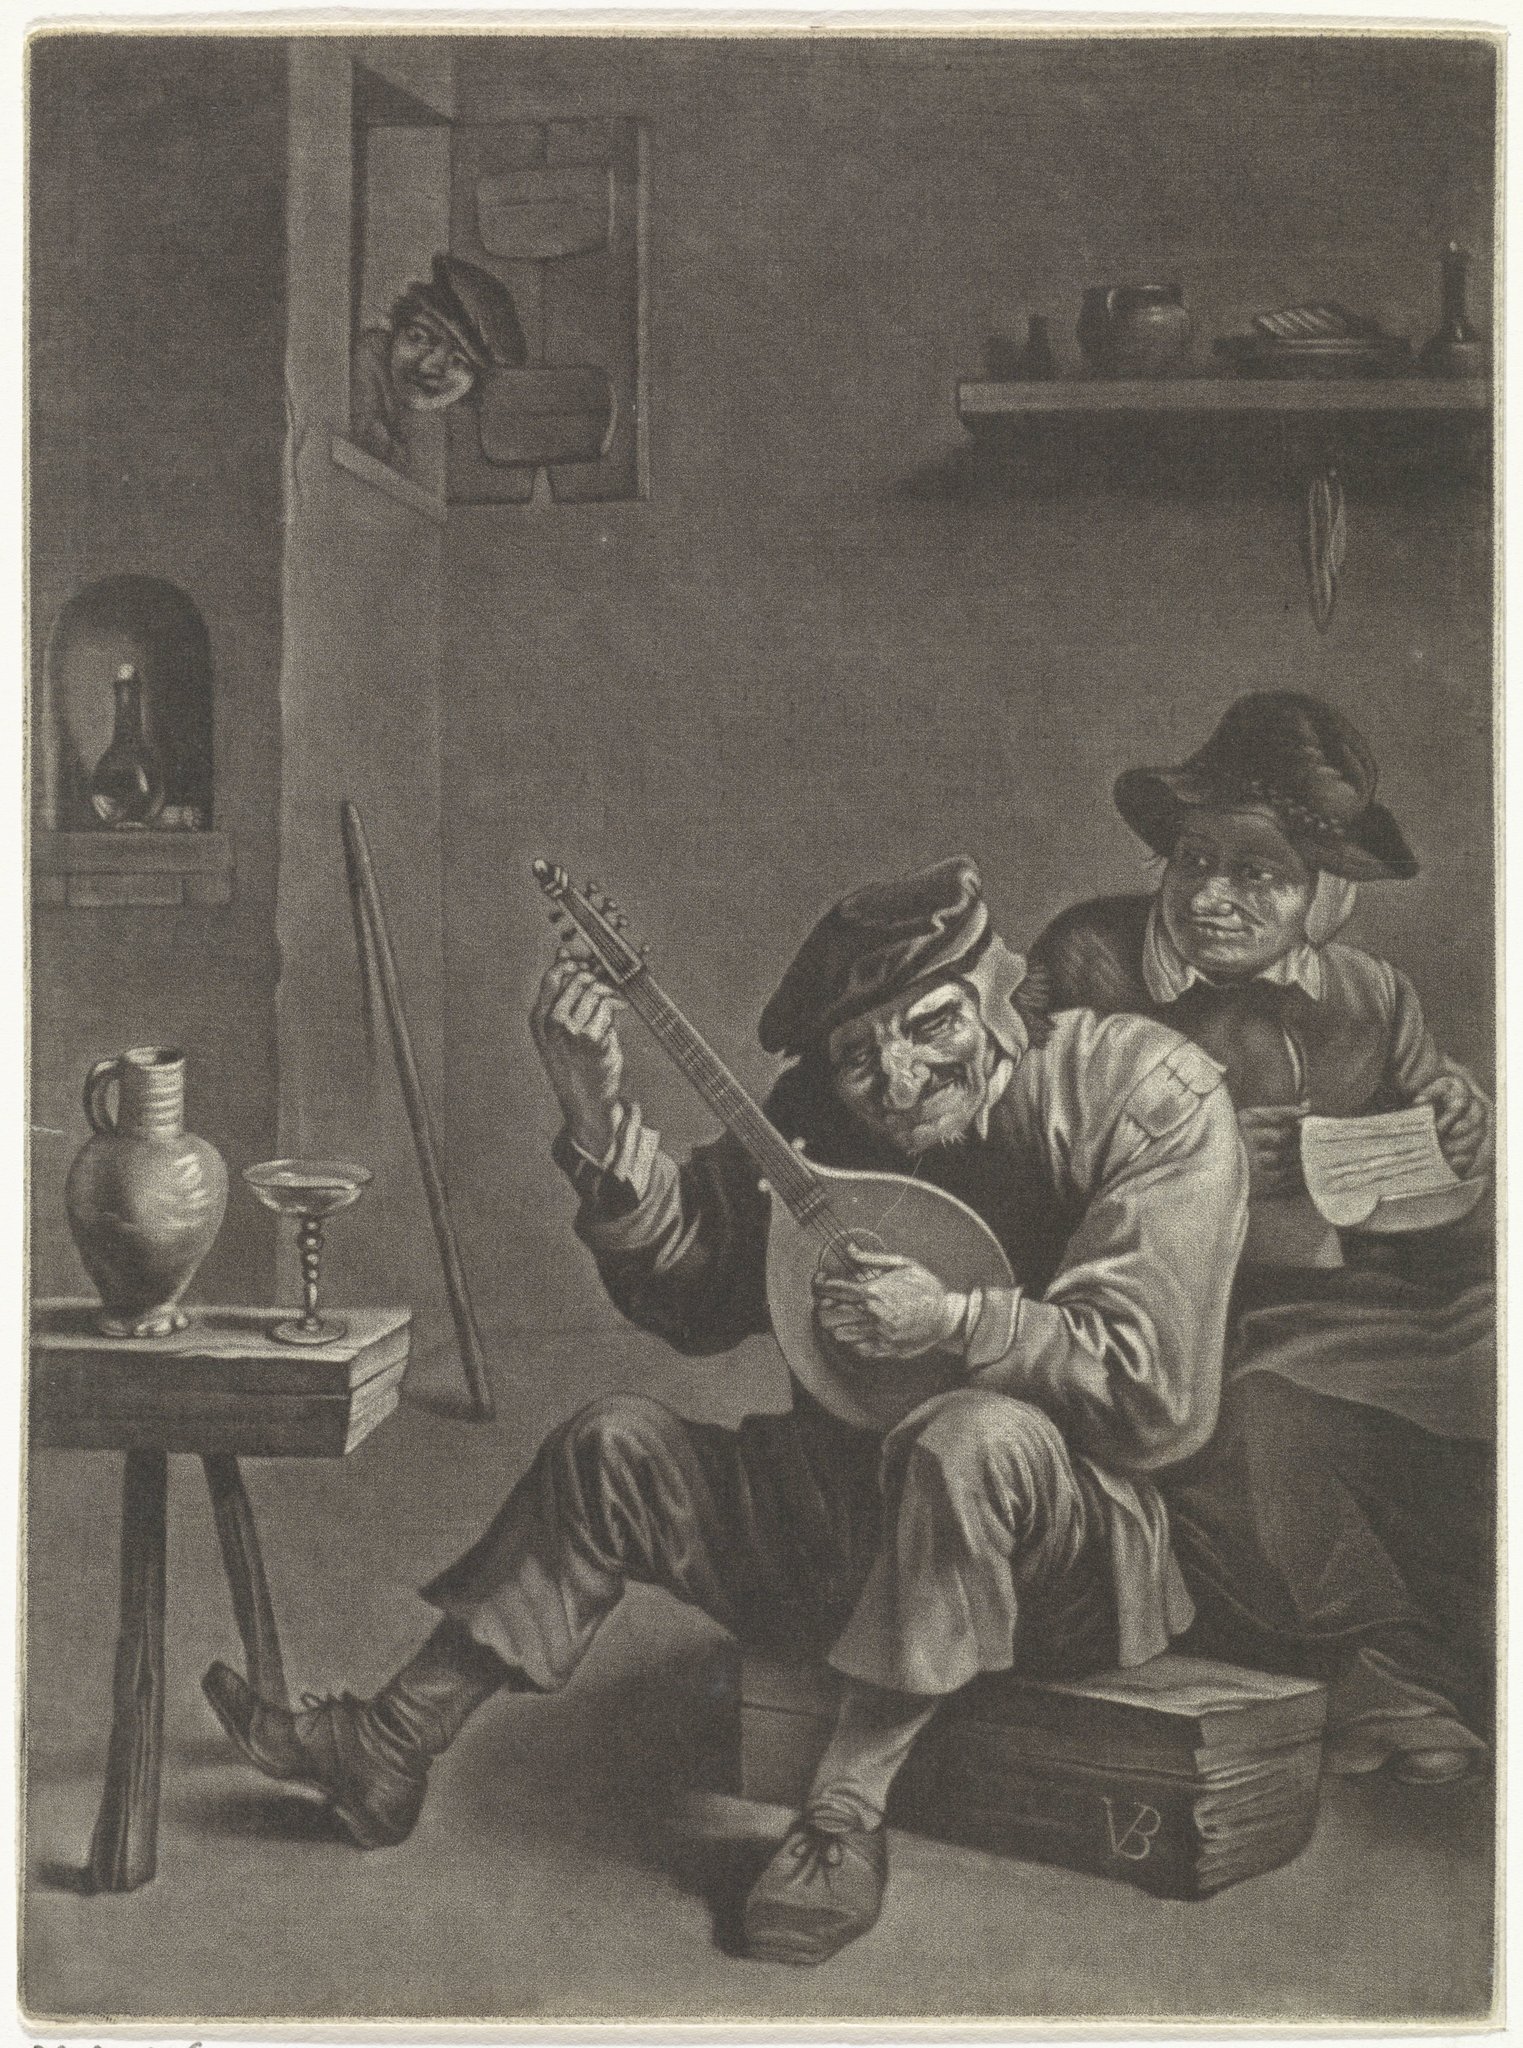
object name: print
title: Oude man stemt een luit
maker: jan van der bruggen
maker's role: draughtsman, print maker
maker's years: 1649-1709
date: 1659-1740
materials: paper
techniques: mezzotint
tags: notation of music, tuning the lute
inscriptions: collector's mark: Lugt 2228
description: In een vertrek stemt een oude man een luit. Achter hem zit een tweede persoon met een vel papier in de hand. Vanuit een luikje slaat een jongen het tafereel gade.